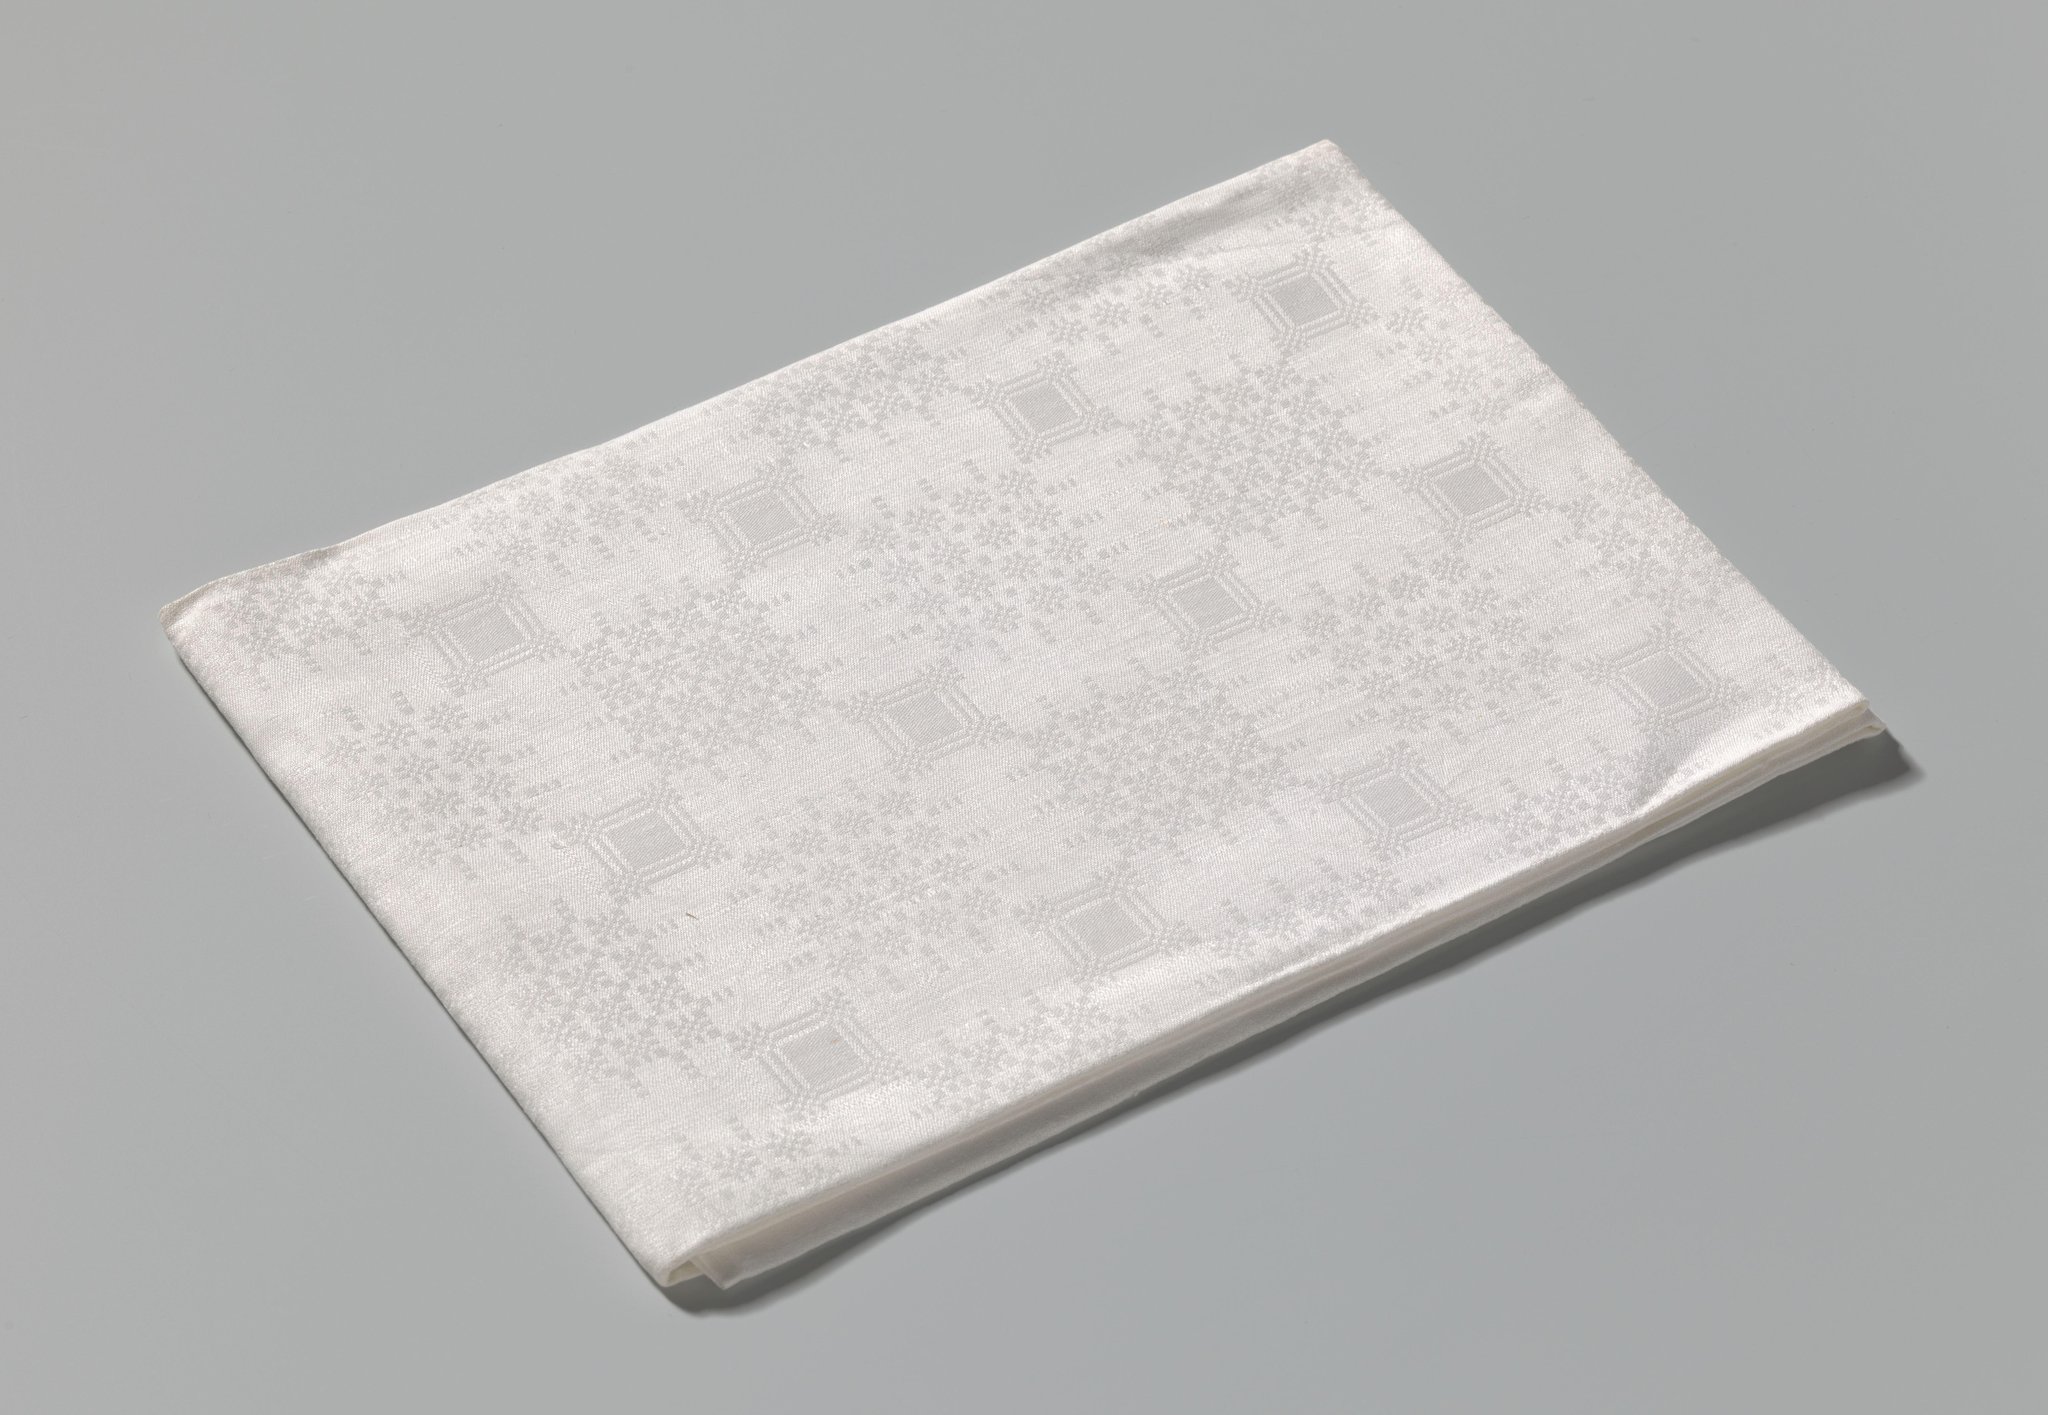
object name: napkin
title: Servet van linnen met pellenpatroon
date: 1700-1800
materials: linen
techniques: peeled fabric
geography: netherlands